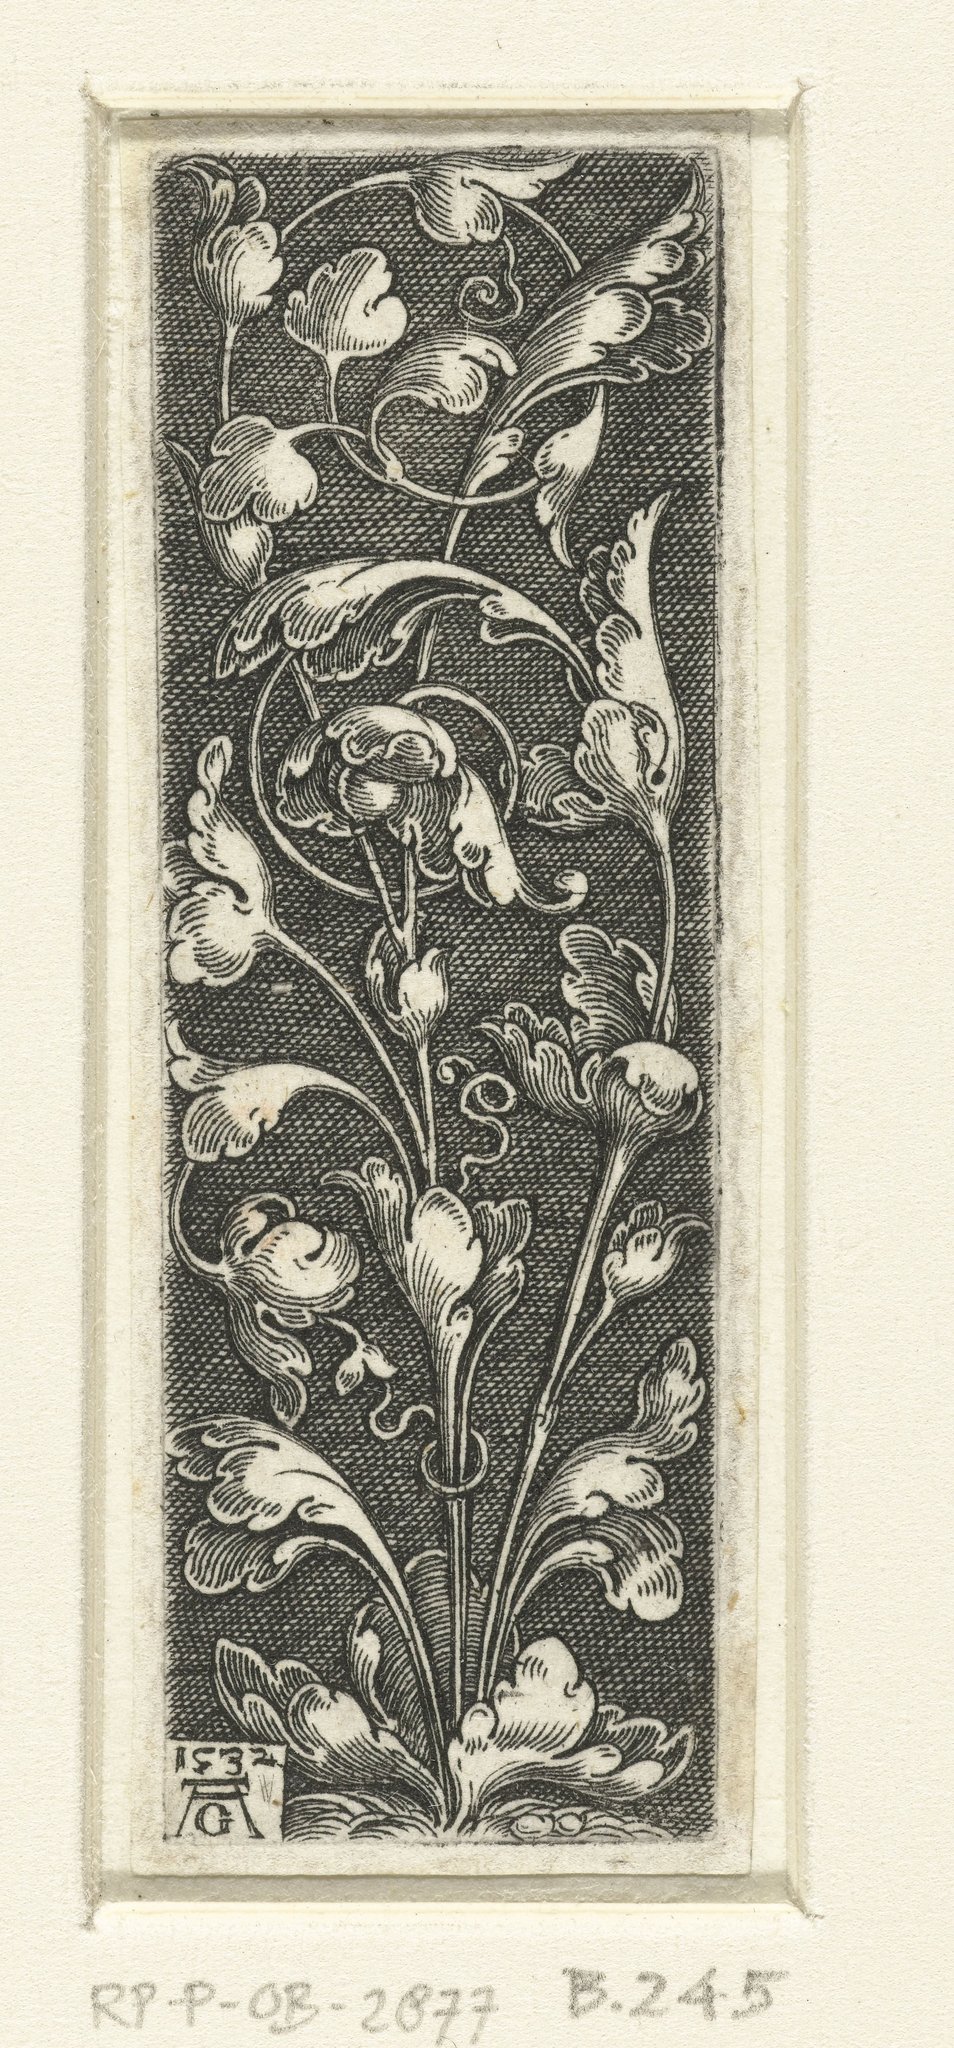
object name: print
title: Bladranken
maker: heinrich aldegrever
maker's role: draughtsman, print maker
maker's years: 1502-1561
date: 1532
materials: paper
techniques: engraving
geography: germany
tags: foliage, tendrils, branches ~ ornament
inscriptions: number: ‘22’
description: Vlakdecoratie met bladranken die zich vanuit een blad verspreiden over het vlak.